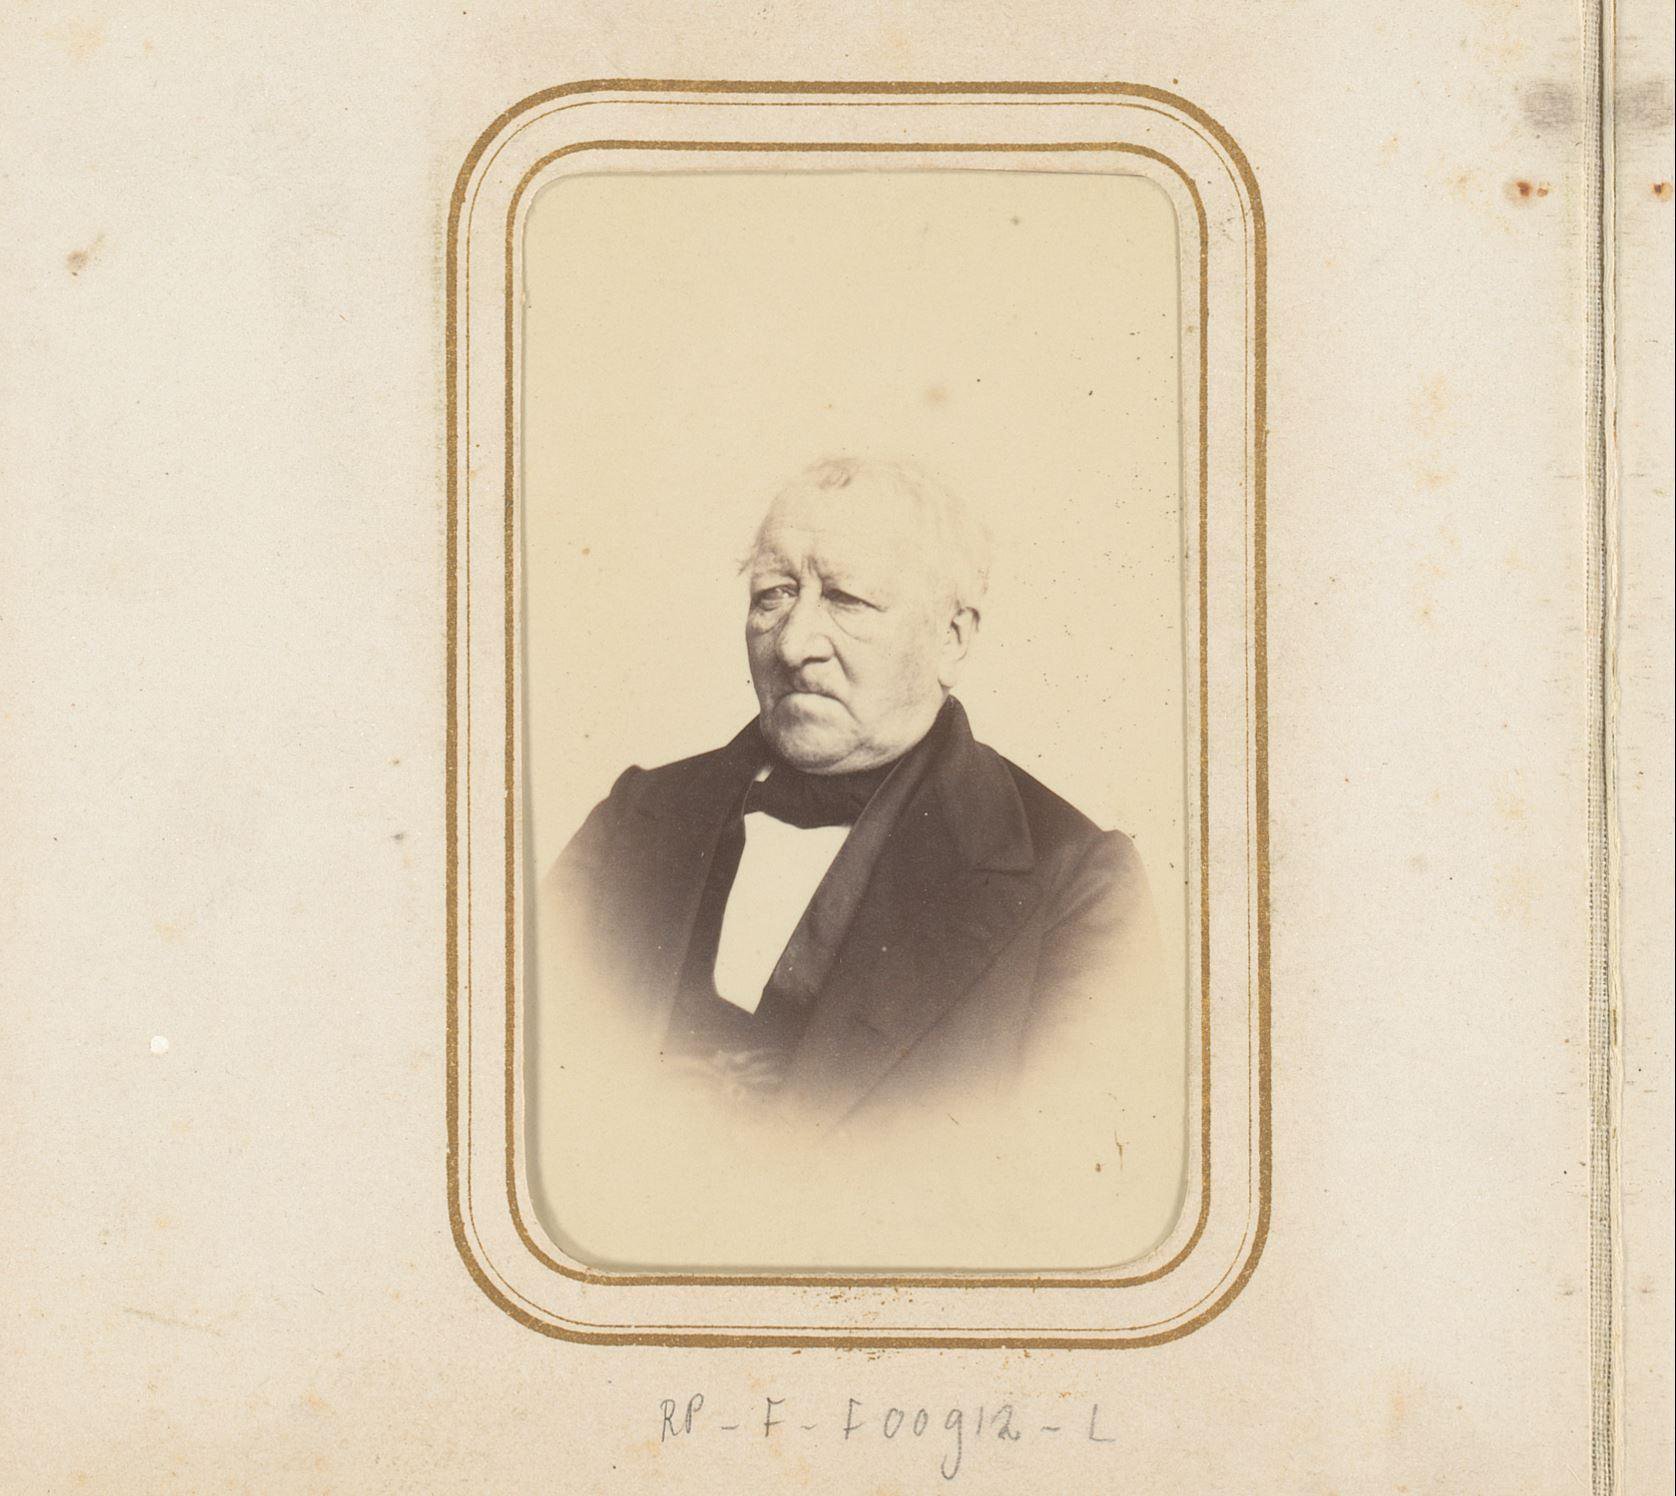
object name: photograph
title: Portret van een oude man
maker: emmanuel adrianus henricus van der ven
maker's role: draughtsman, painter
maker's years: 1821-1883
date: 1850-1883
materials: cardboard, photographic support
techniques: albumen print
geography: den bosch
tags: historical persons, old man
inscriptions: inscription: ‘Em. van der Ven/ Artiste-peintre/ Bois-le-Duc’